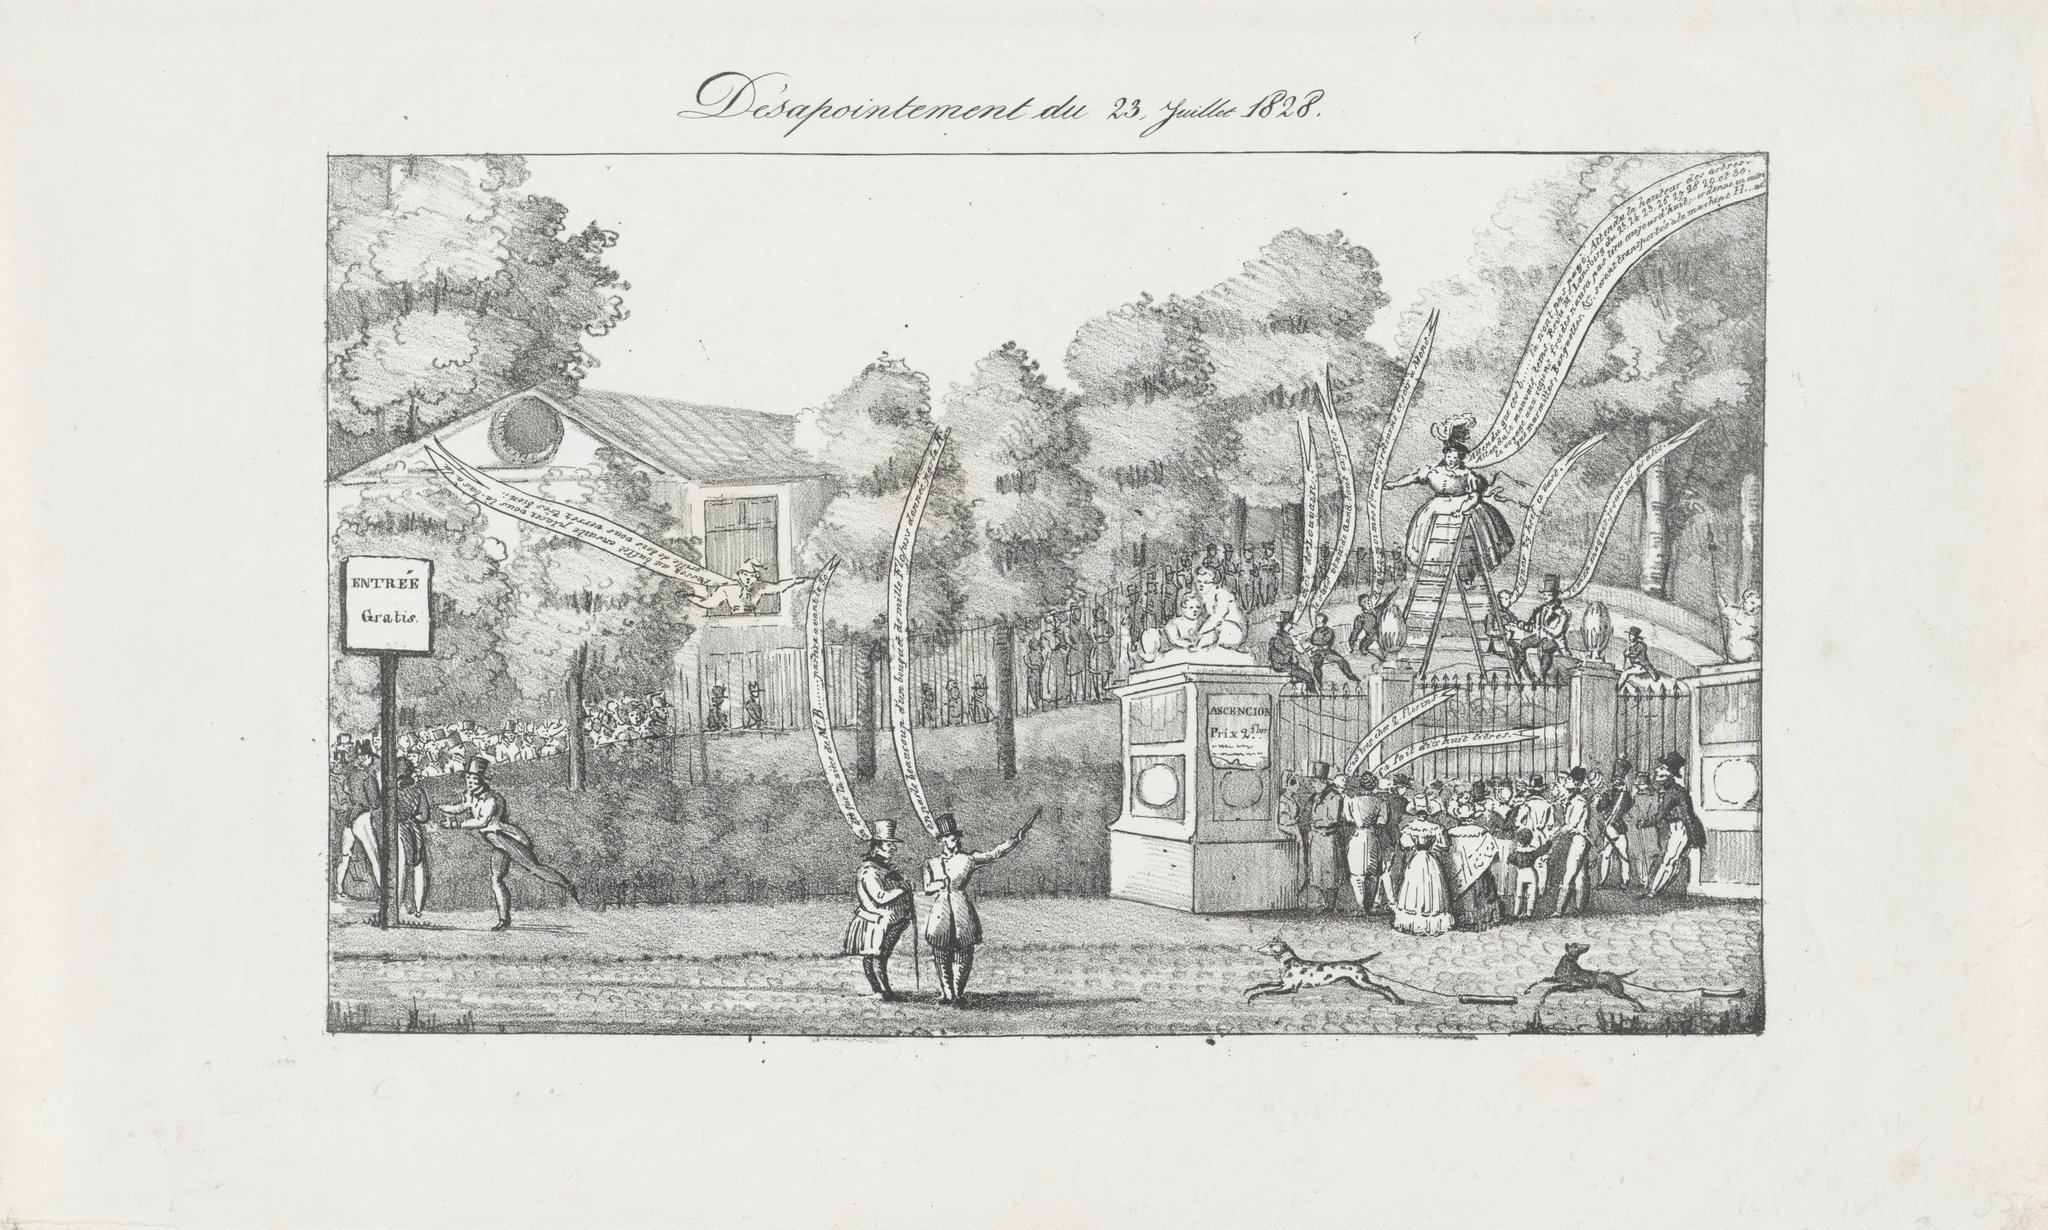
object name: cartoon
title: Désapointement du 23 Juillet 1828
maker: Anonymous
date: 1828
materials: paper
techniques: lithograph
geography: southern netherlands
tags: balloon flight (sport), brussels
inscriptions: collector's mark: Lugt 2228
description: Teleurgestelde bezoekers in het Parc Royal te Brussel waar mej. Elisa Garnerin bekend maakt dat haar ballonvaart niet doorgaat wegens ongunstig weer, 23 juli 1828 . De vrouw doet haar aankondiging staande bovenop een trap.